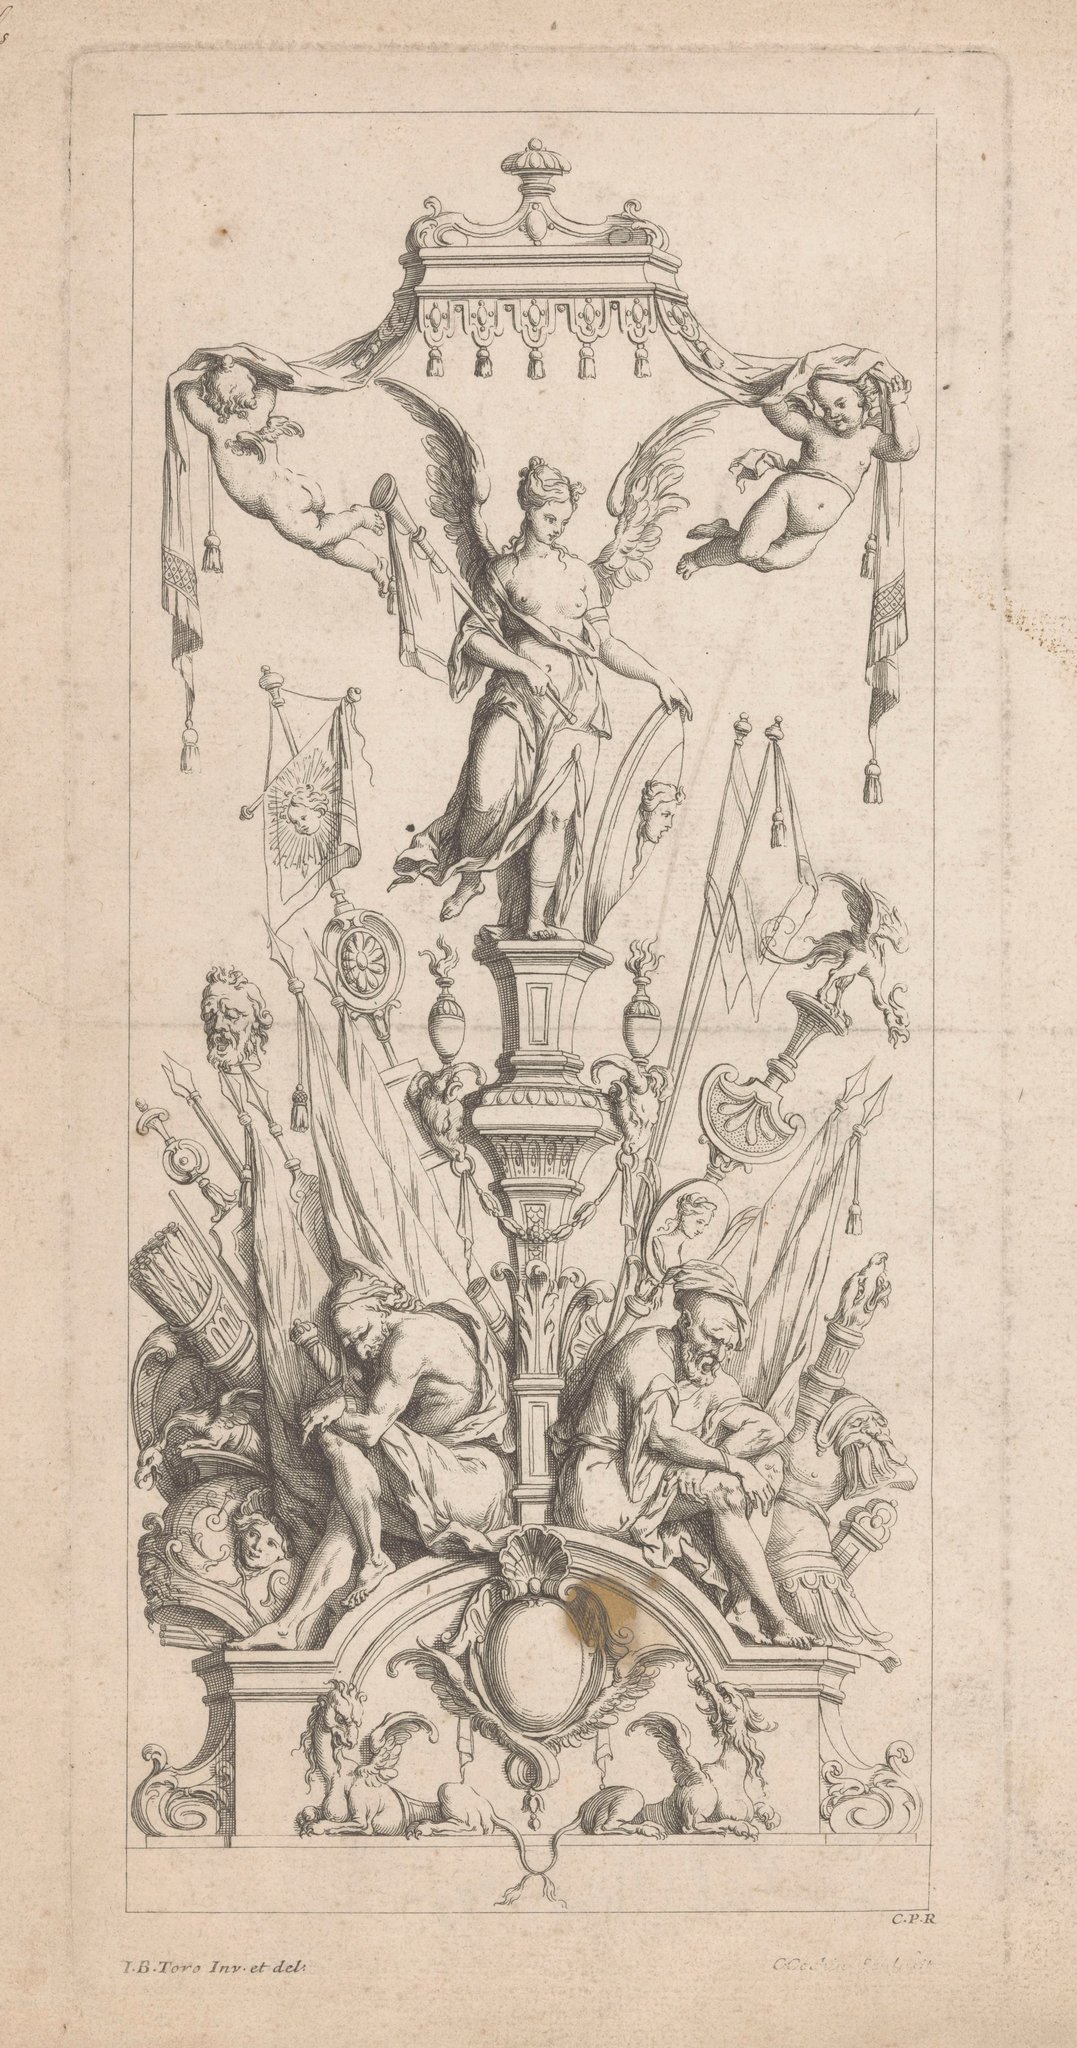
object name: print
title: Trophées Nouvellement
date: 1698-1754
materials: paper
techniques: etching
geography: paris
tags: trophy, i.e.: decorative arrangement of symbolic or typical objects ~ ornament, weapons, angels, (military) flags and standards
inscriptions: collector's mark: Lugt 2228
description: Een trofee met een vrouwelijke engel met een schild en een bazuin. Ze staat op een hoog voetstuk onder een baldakijn met draperieën vastgehouden door putti. Aan weerszijden van het voetstuk zit een oude man. Rondom de mannen vlaggen, harnassen en wapens. Aan de onderzijde een cartouche geflankeerd door fantasiedieren.